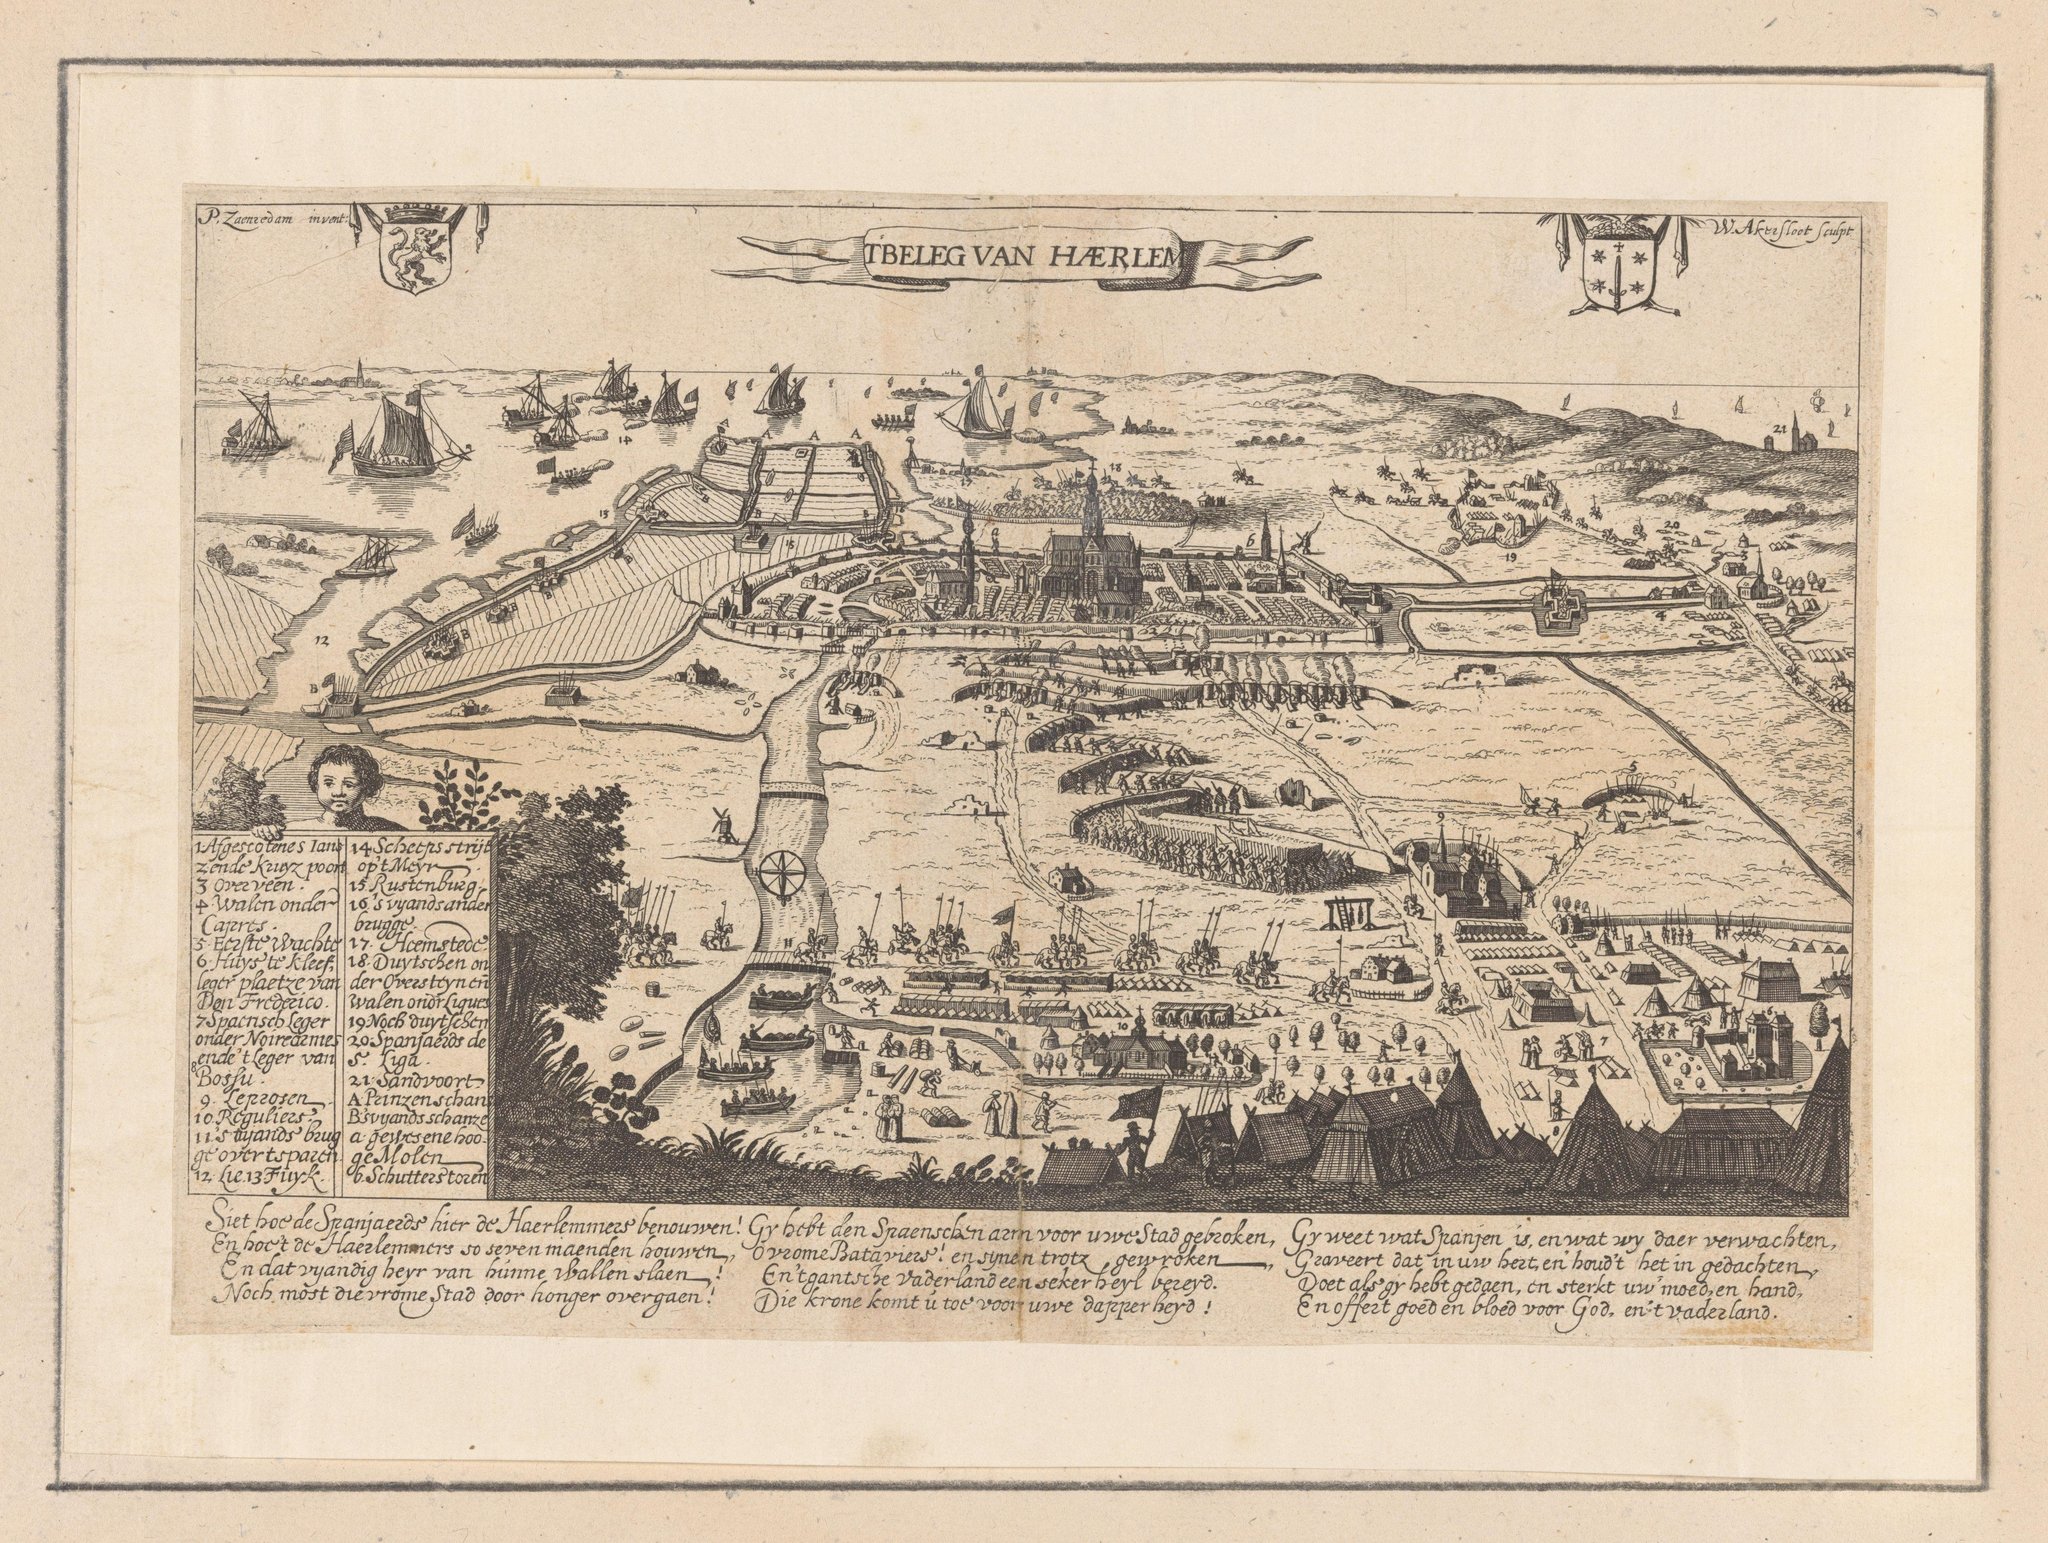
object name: history print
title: Het beleg van Haarlem, 1572-1573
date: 1628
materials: paper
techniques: engraving, etching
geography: haarlem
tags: siege, position war, haarlem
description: Overzicht van het beleg van de stad Haarlem met het omringend gebied in vogelvluchtperspectief. Op de voorgrond de legerplaats van de Spaanse troepen bij het Huis ter Kleef. Linksboven het wapen van Holland, rechtsboven het wapen van Haarlem. Linksonder een cartouche opgehouden door een jonge man met de legenda 1-21, A-B en a-b in het Nederlands. Bovenaan een vaandel met de titel en de wapens van Holland en Haarlem. Met onderschrift van drie verzen van vier regels in het Nederlands: Siet hoe de Spanjaerds hier de Haerlemmers benouwen! [...].